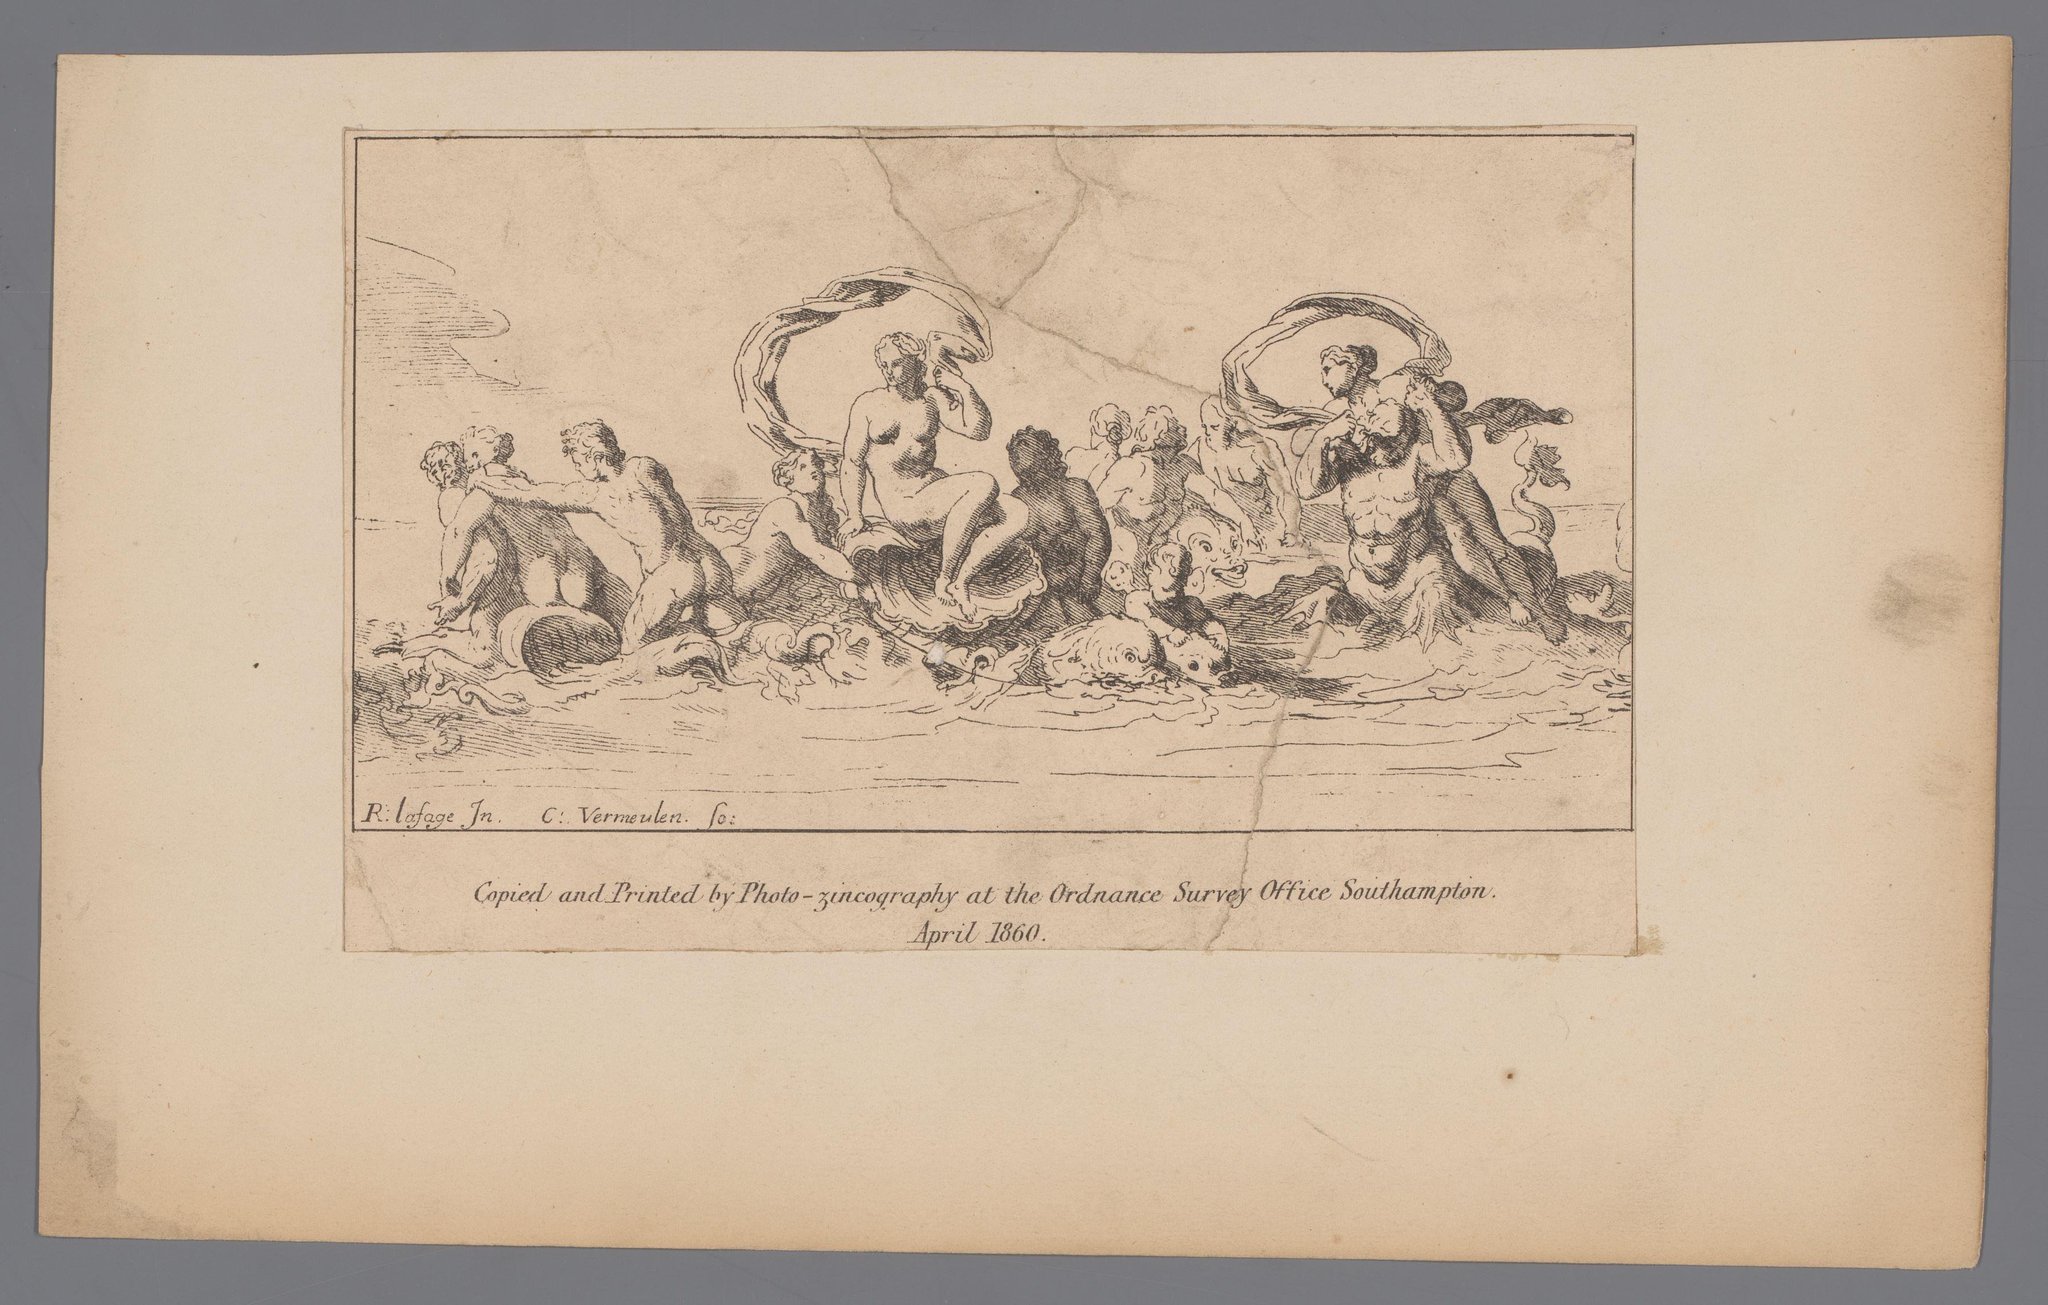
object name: photograph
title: Repro naar ets door Lafage Jn en Vermeulen van zeewezens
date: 1861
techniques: photo-zincography